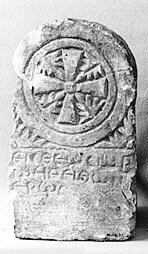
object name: stele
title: Inscribed Stele with a Cross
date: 501-700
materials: limestone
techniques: carving, incising, relief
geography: egypt